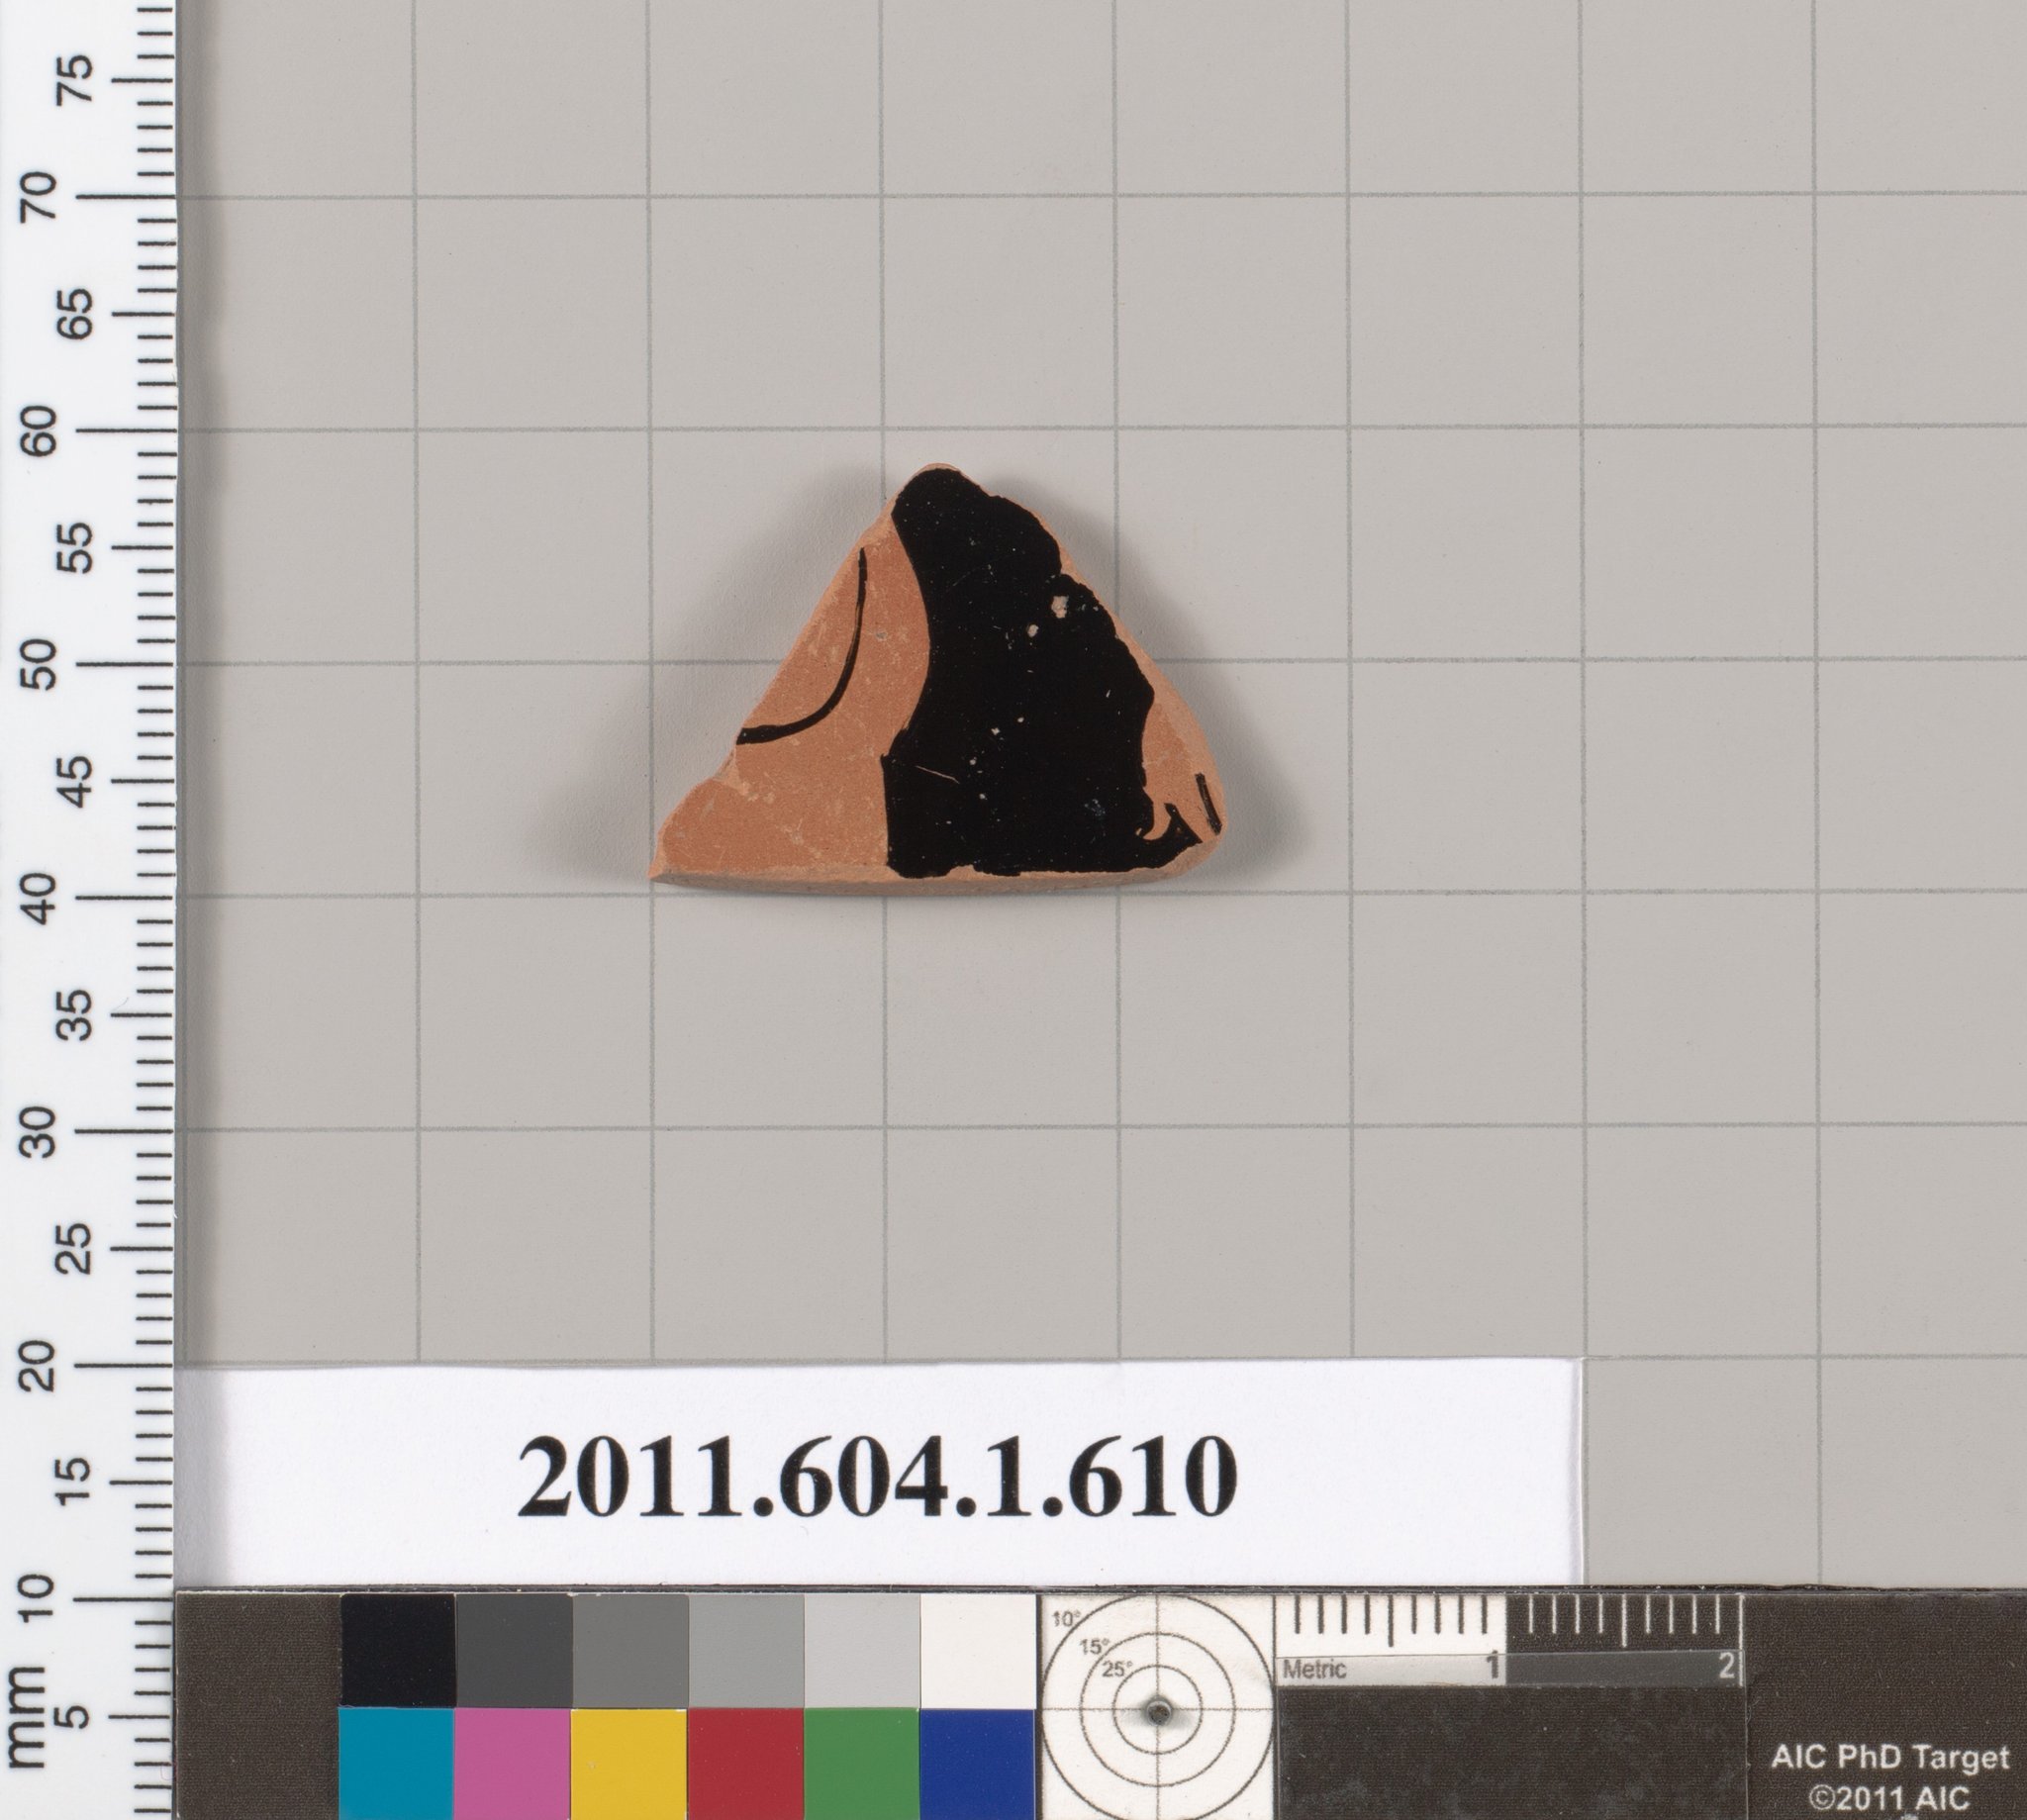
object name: kylix fragment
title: Terracotta fragment of a kylix (drinking cup)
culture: greek, attic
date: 475-451 BCE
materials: terracotta